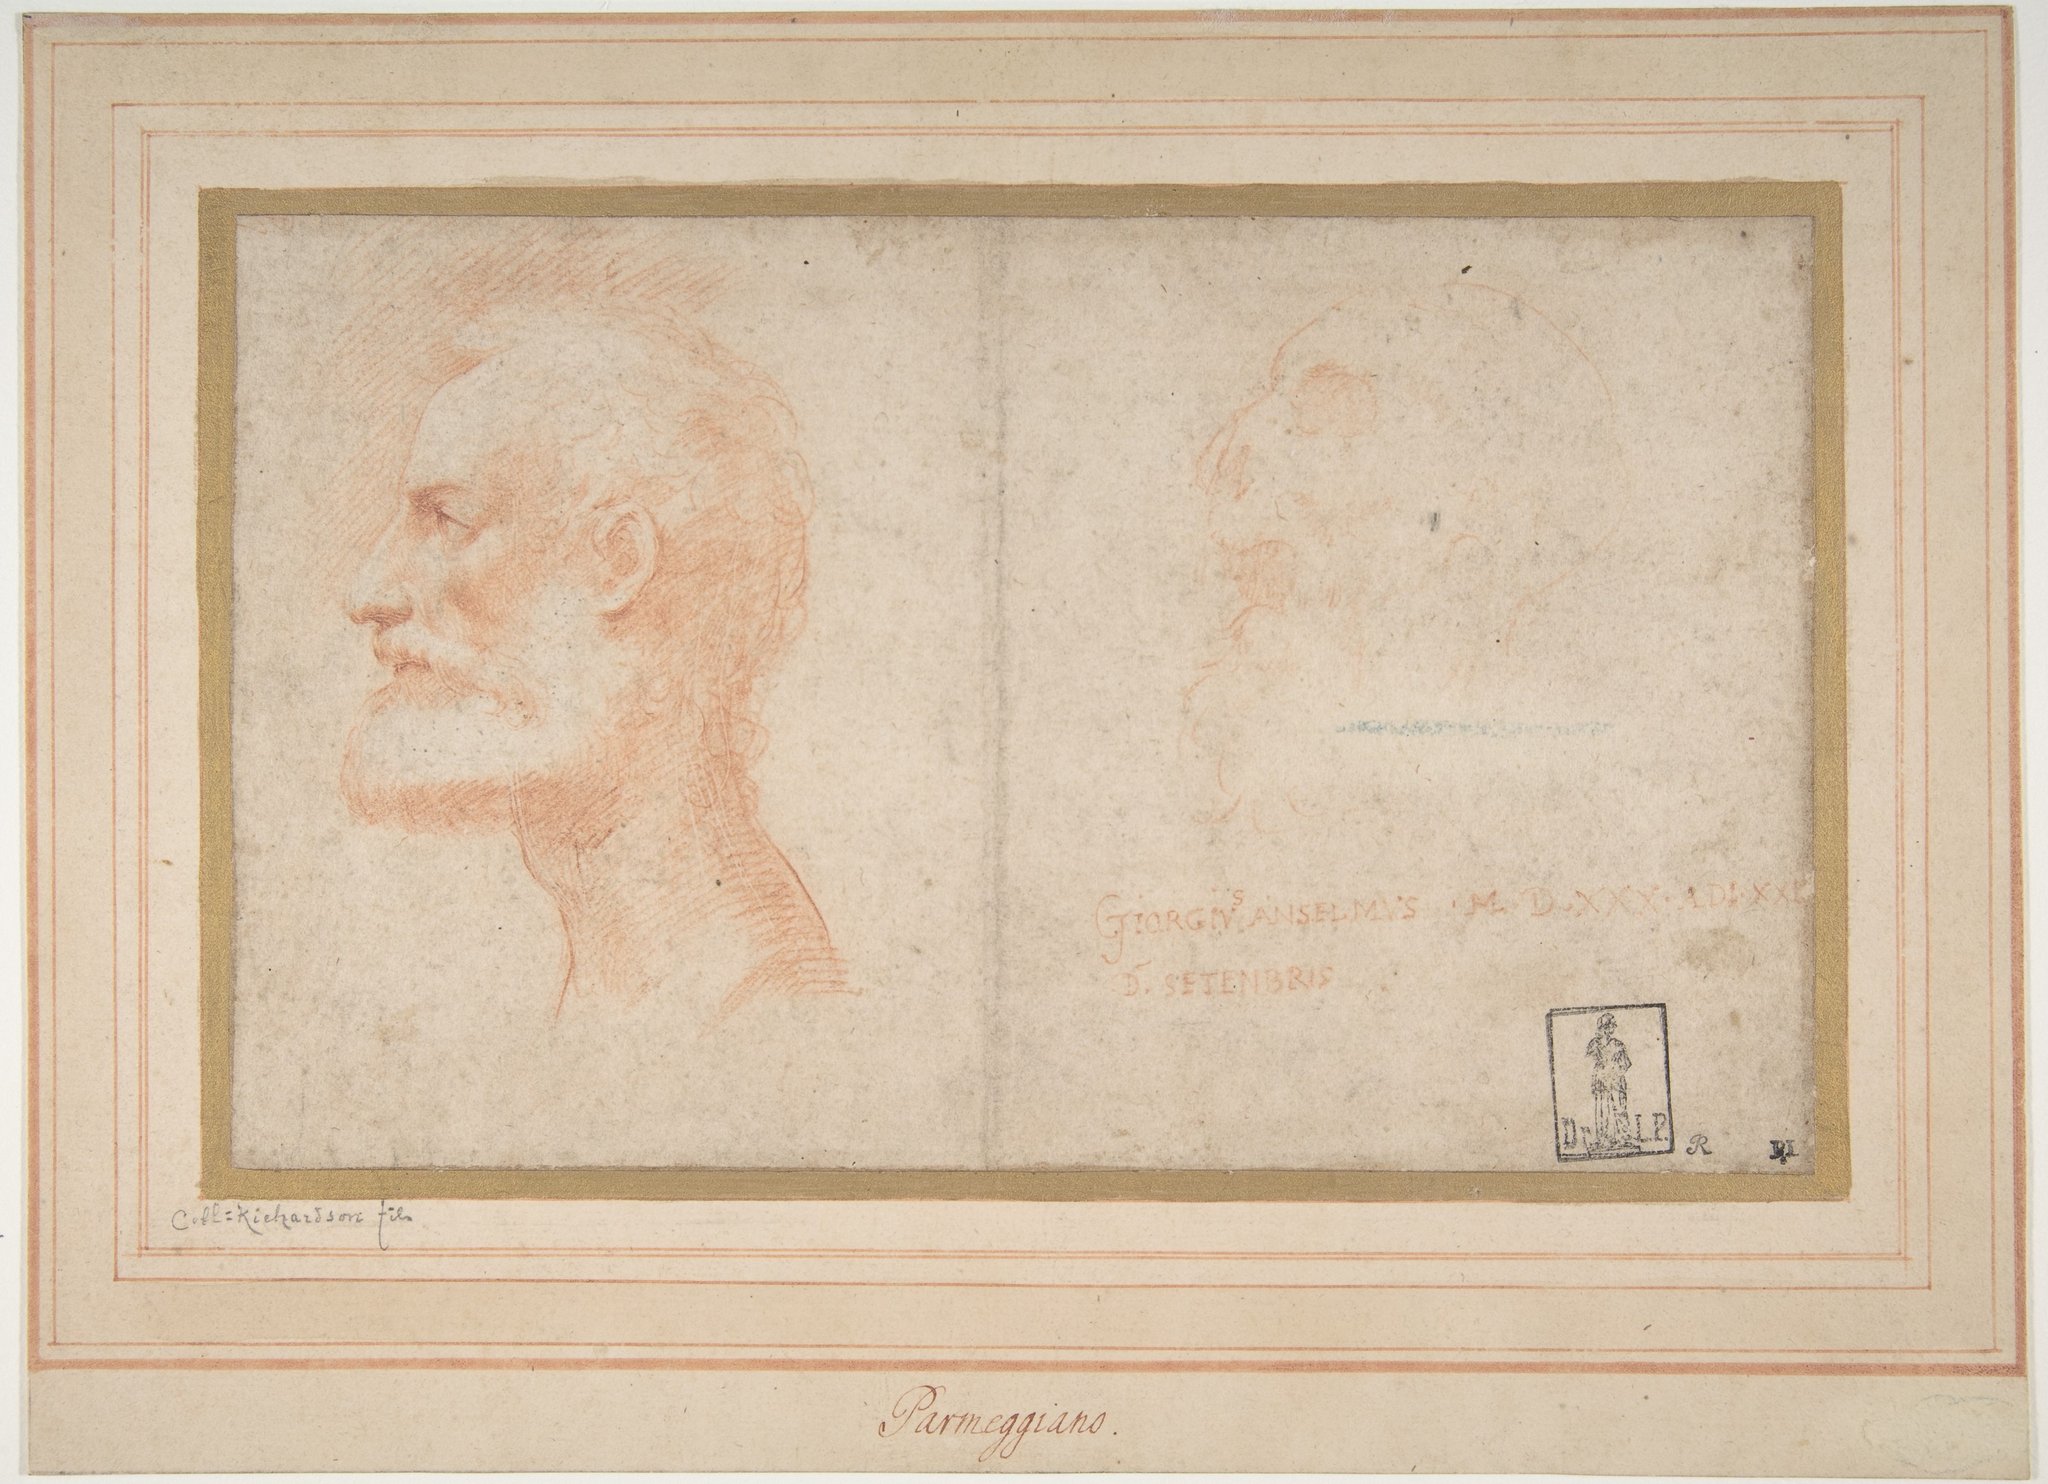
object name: drawing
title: Head of a Bearded Man in Profile to Left, possibly the Portrait of the Poet Giorgio Anselmi (ca. 1459-1528), with Faint Sketch of a Skull-like Head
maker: parmigianino (girolamo francesco maria mazzola)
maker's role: artist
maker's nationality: italian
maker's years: 1503-1540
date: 1503-1540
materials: chalk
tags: men,profiles